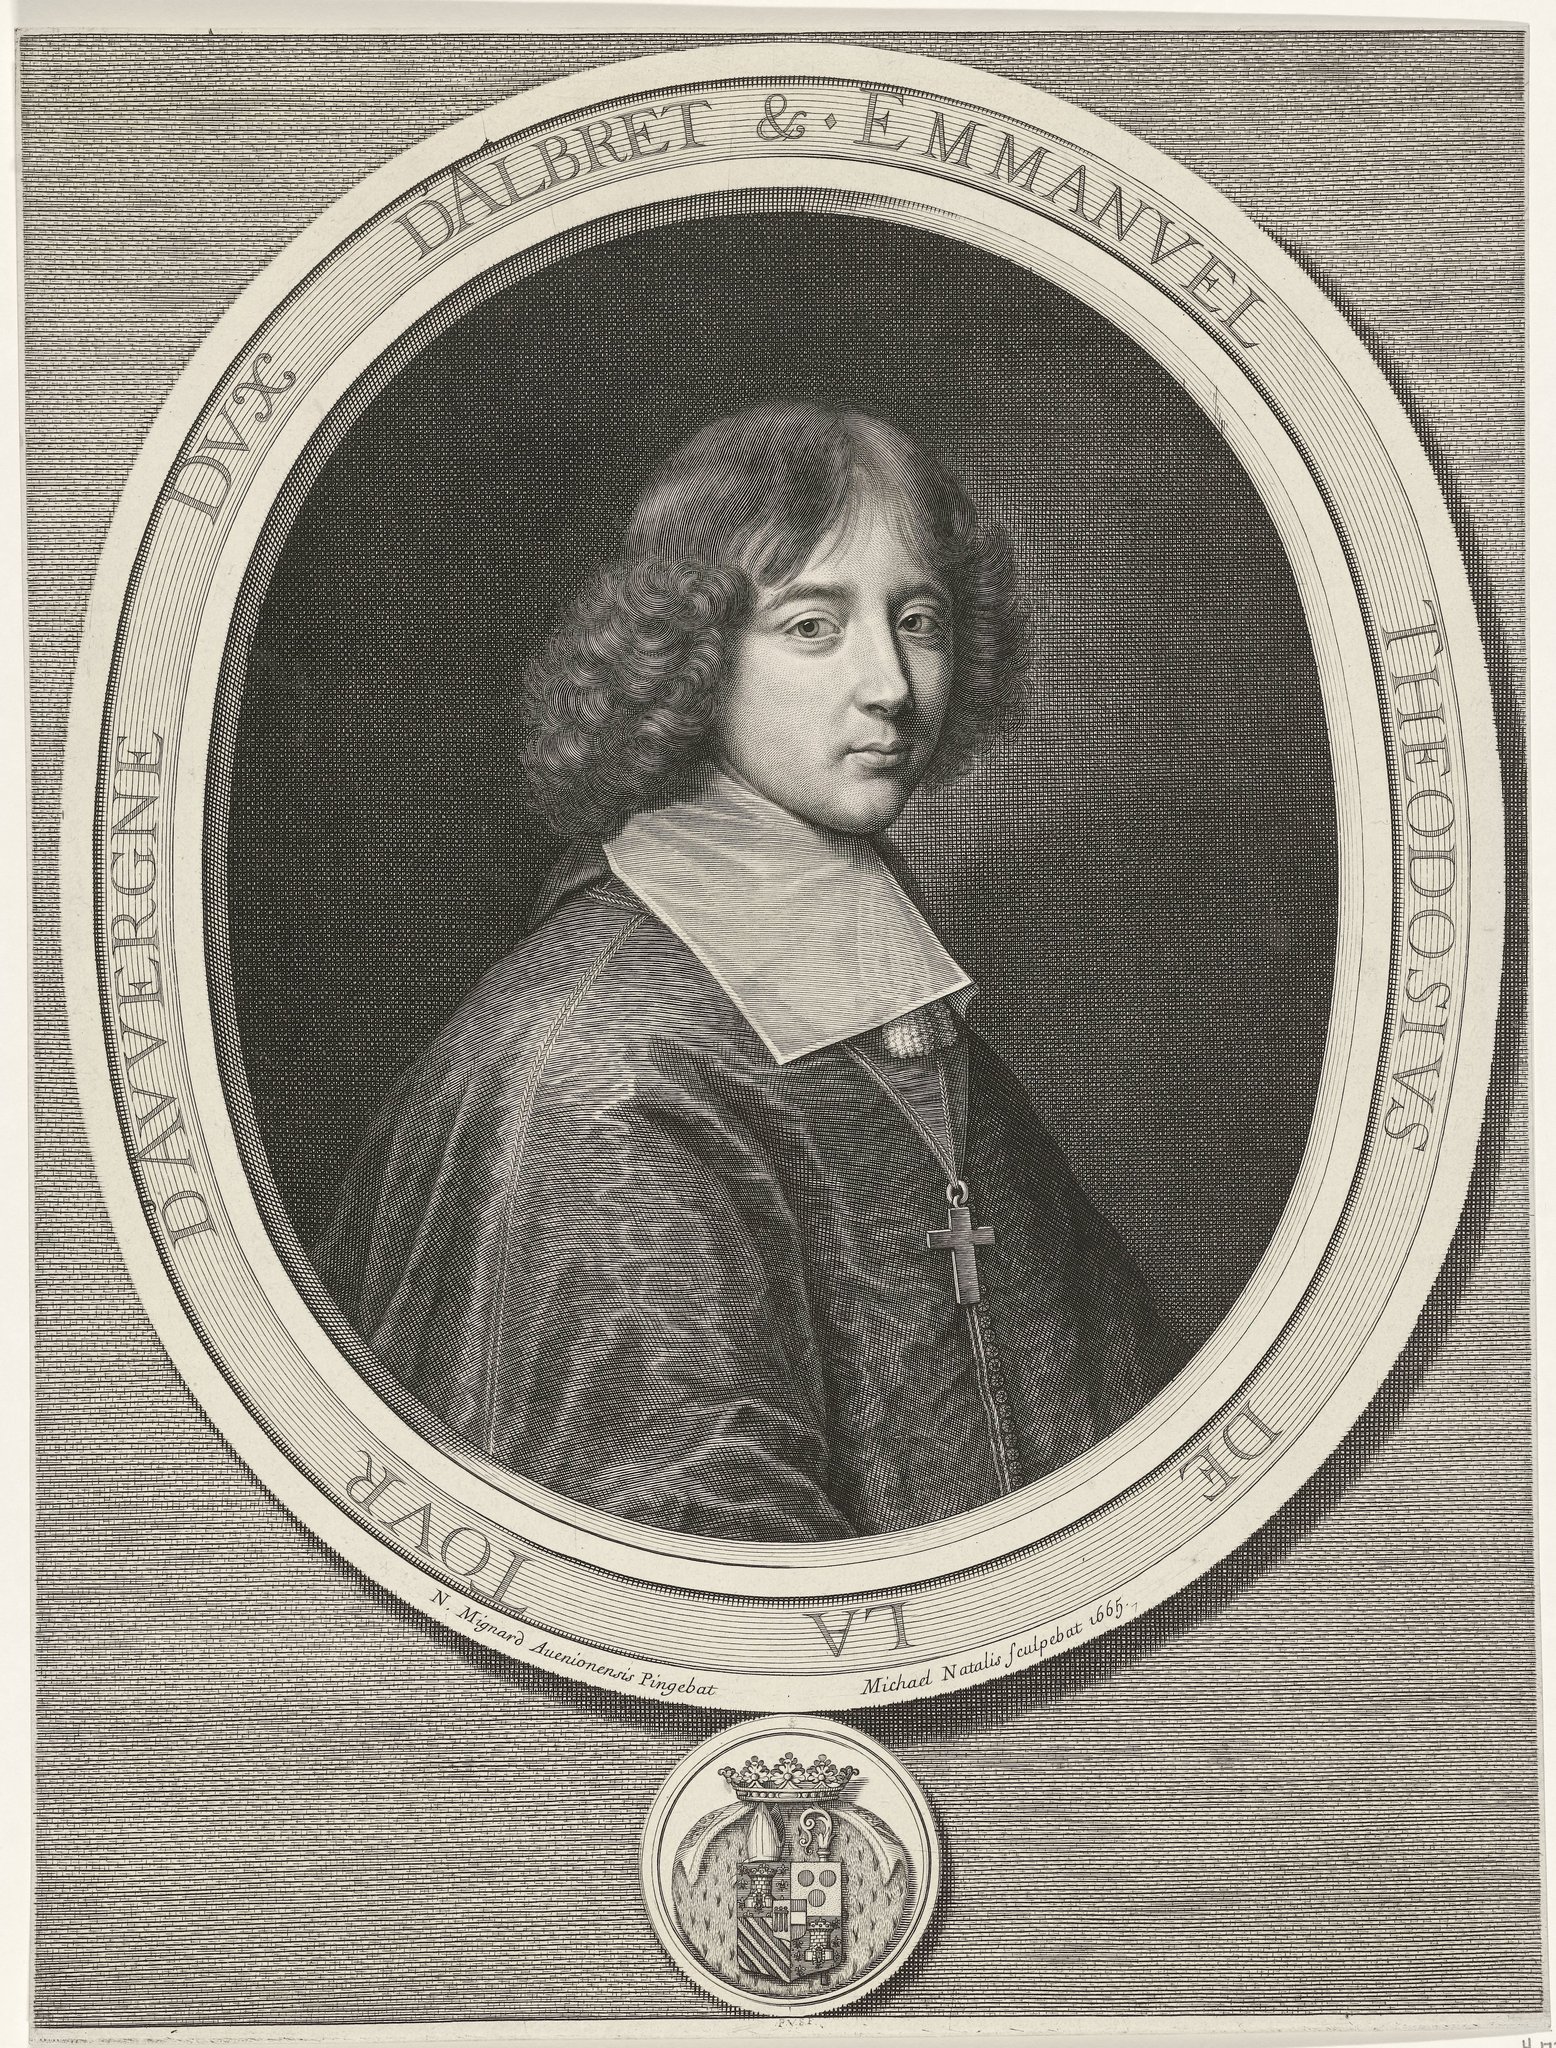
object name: print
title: Portret van kardinaal Emmanuel Théodore de la Tour d'Auvergne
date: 1665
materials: paper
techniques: engraving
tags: rome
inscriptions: inscription: ‘Petrus van Schuppen fecit.’, collector's mark: Lugt 2228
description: Portret van Emmanuel Théodore de la Tour d'Auvergne, kardinaal van Bouillon, dragende een kruis op zijn borst. Buste naar rechts in ovaal met randschrift. Onderaan in de marge zijn wapen.